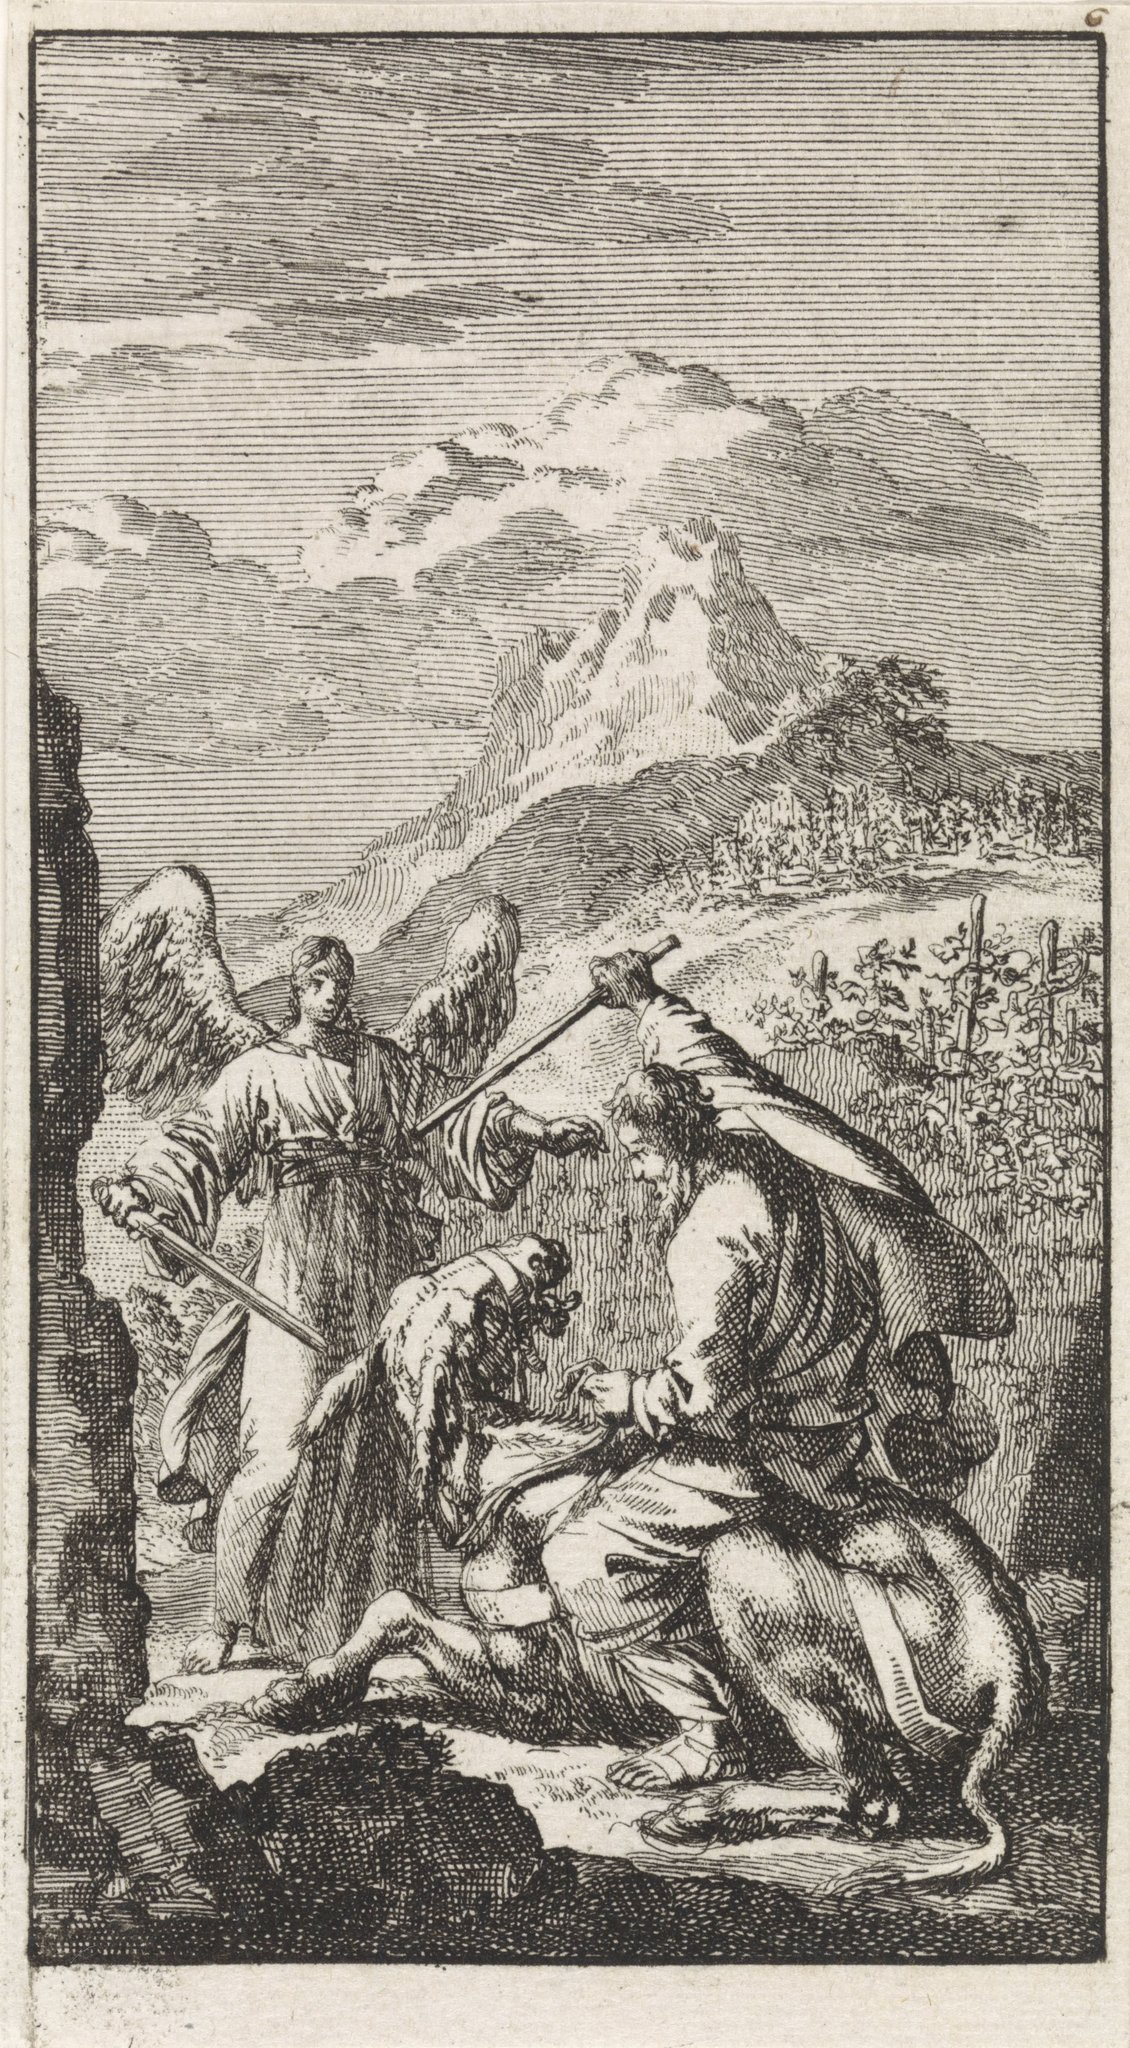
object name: print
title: Bileam en zijn ezel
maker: jan luyken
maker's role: draughtsman, print maker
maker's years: 1649-1712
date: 1712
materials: paper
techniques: etching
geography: amsterdam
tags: an angel holding a sword bars the way and causes balaam's ass to turn aside; the angel is invisible to balaam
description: Proefdruk van illustratie voor: Luyken, Jan. Bybel printen. Amsterdam: Pieter Arentsz. II (wed.) en Cornelis van der Sys, 1712, p. 7.